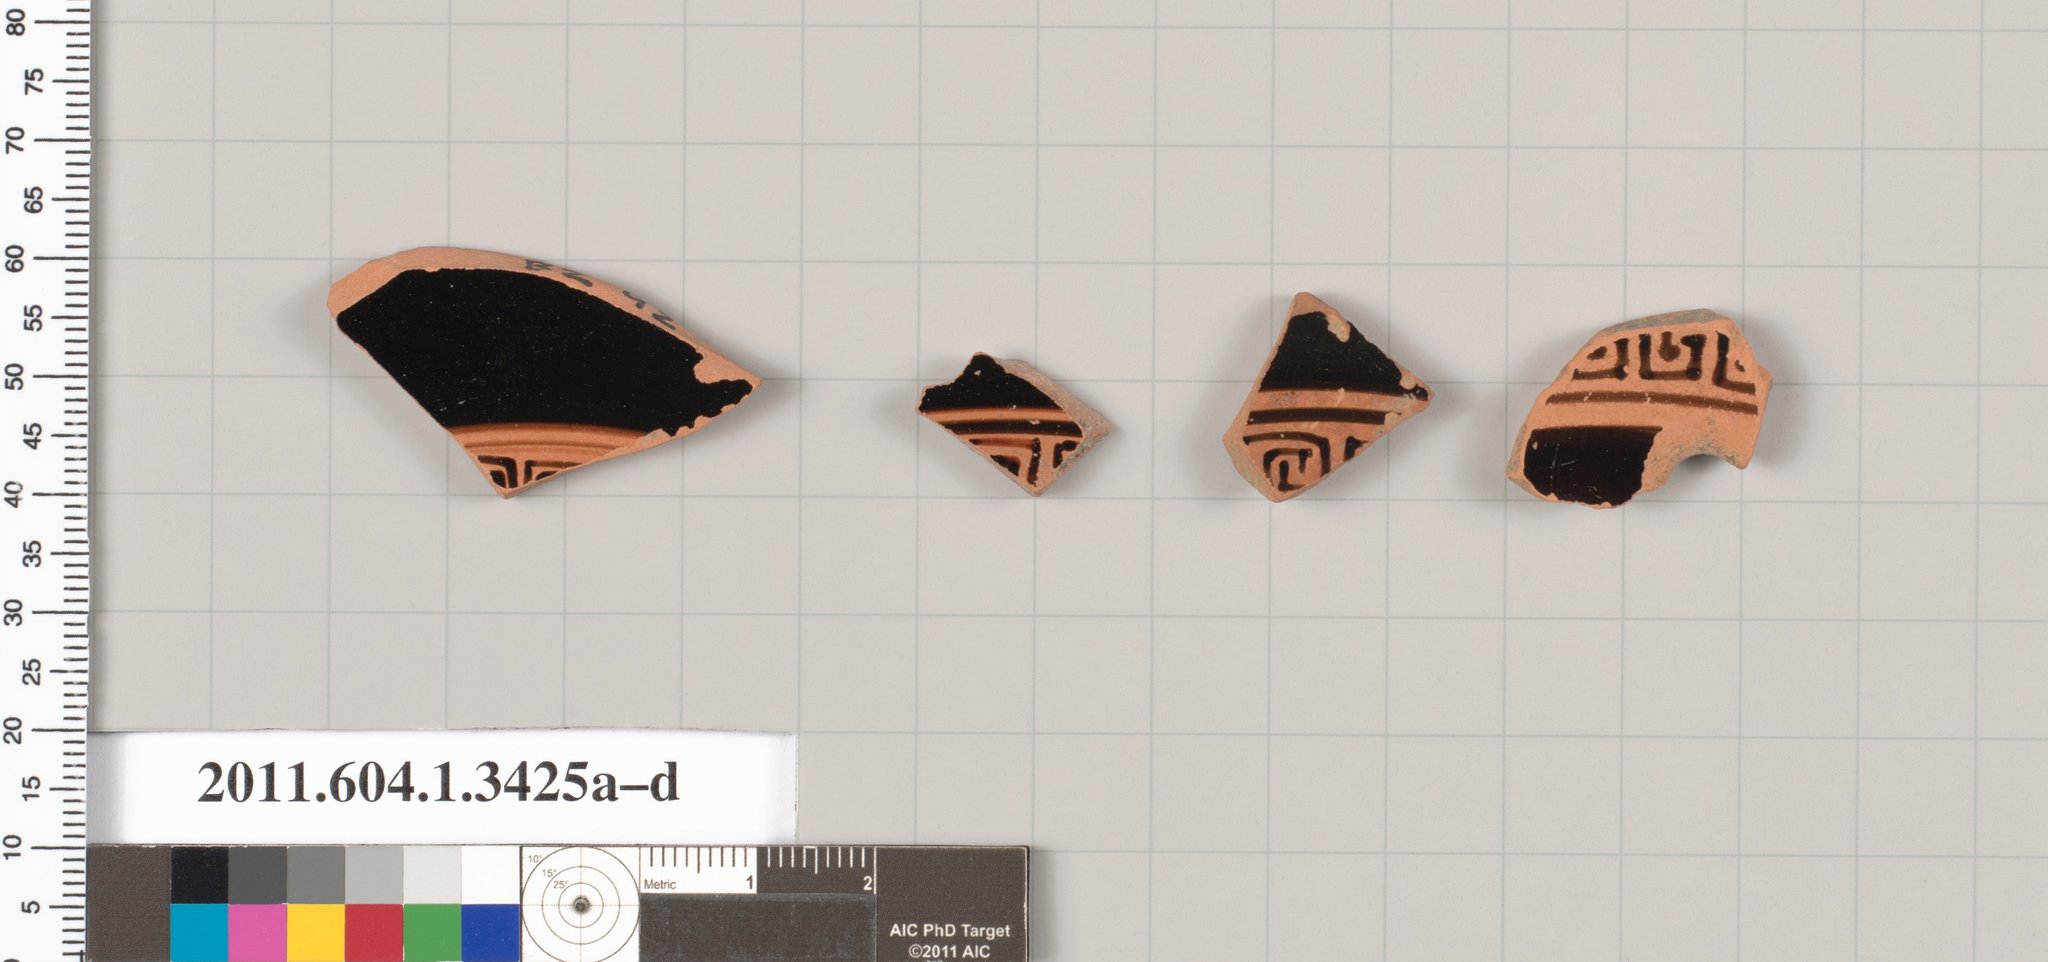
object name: kylix fragment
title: Terracotta fragments of kylikes (drinking cups)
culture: greek, attic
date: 500-470 BCE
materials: terracotta